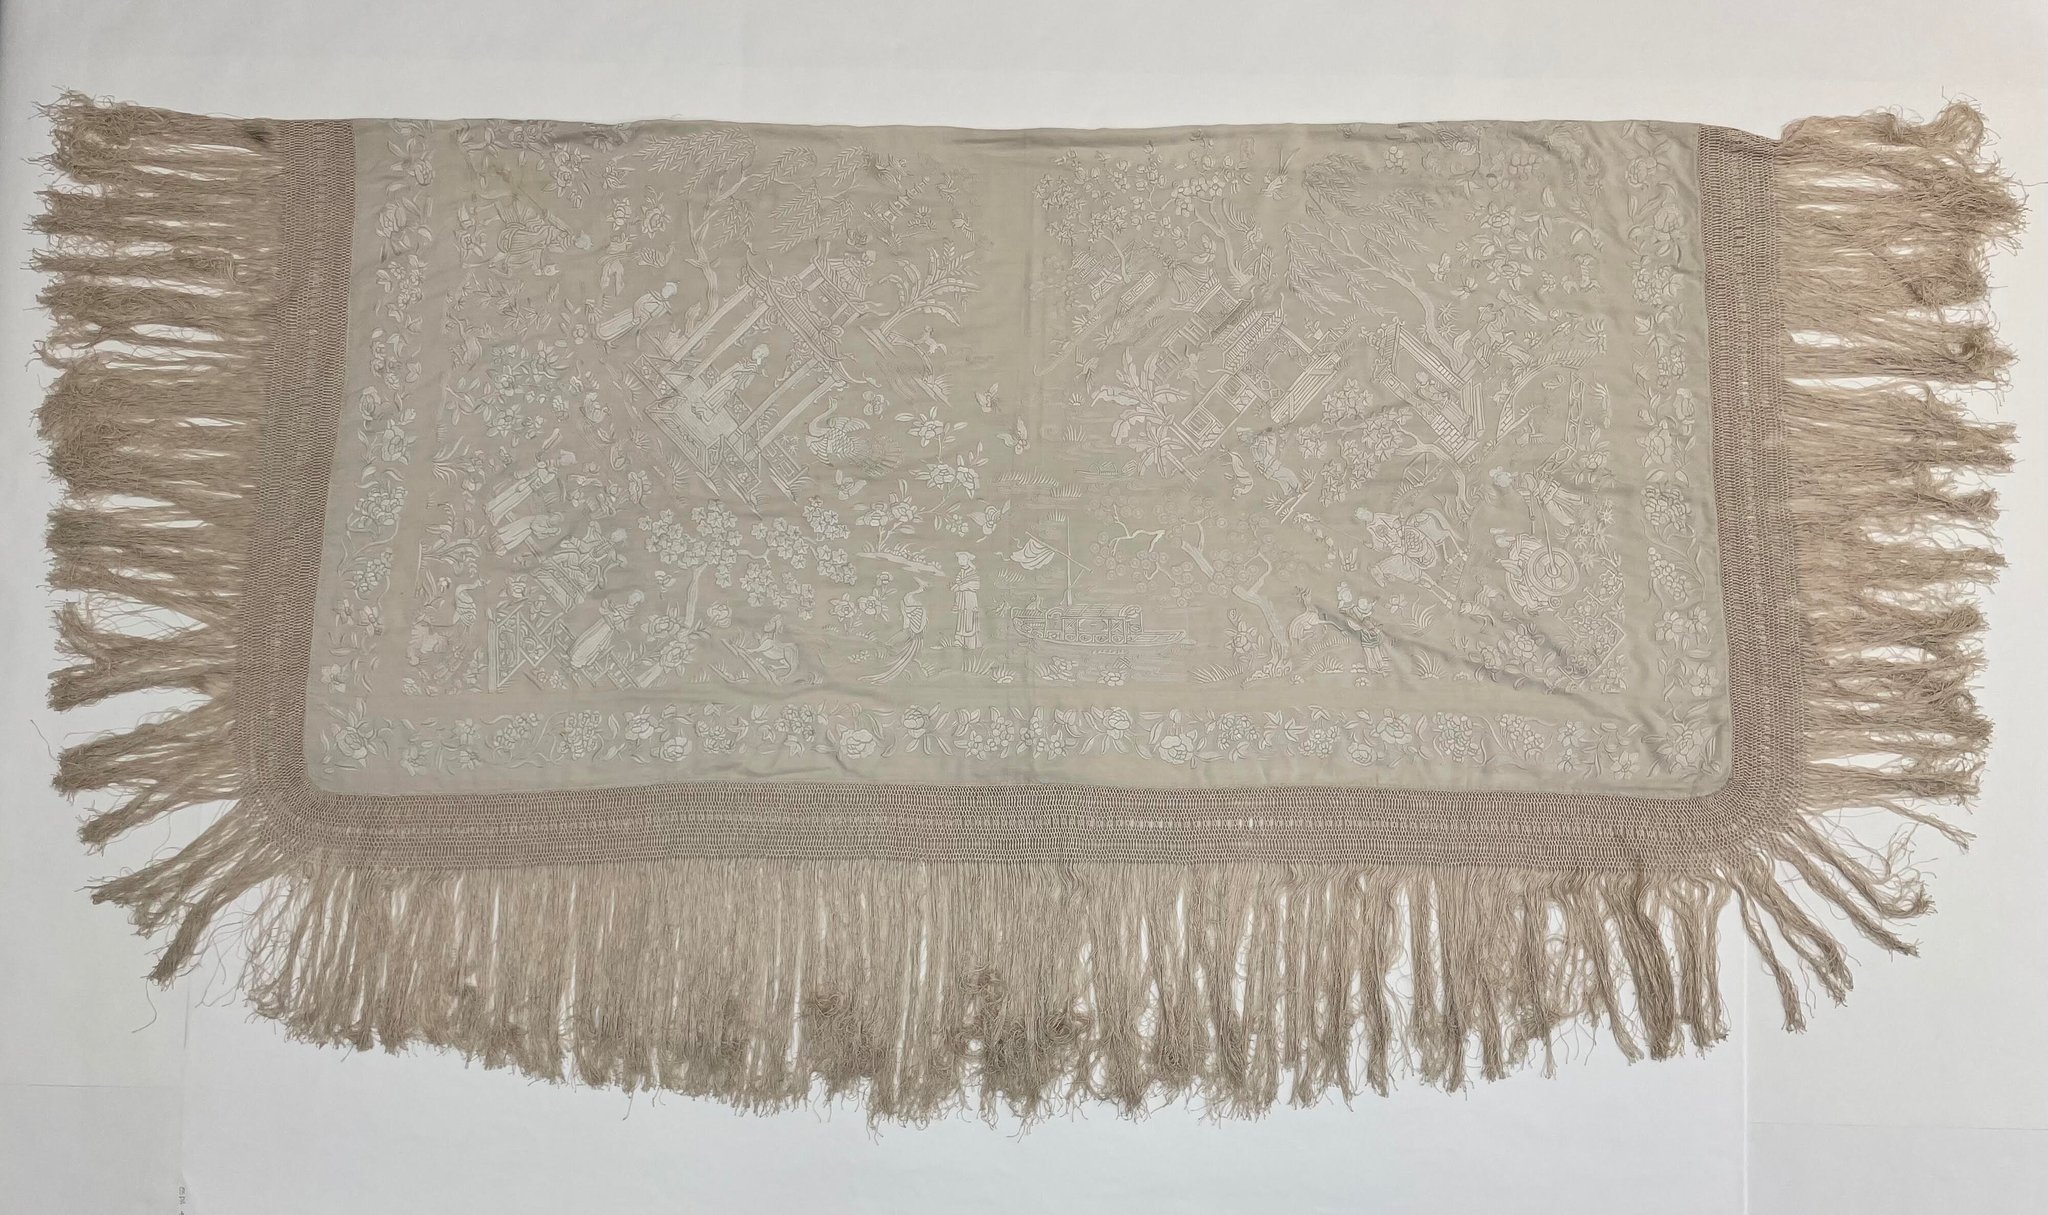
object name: shawl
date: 1801-1900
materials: silk